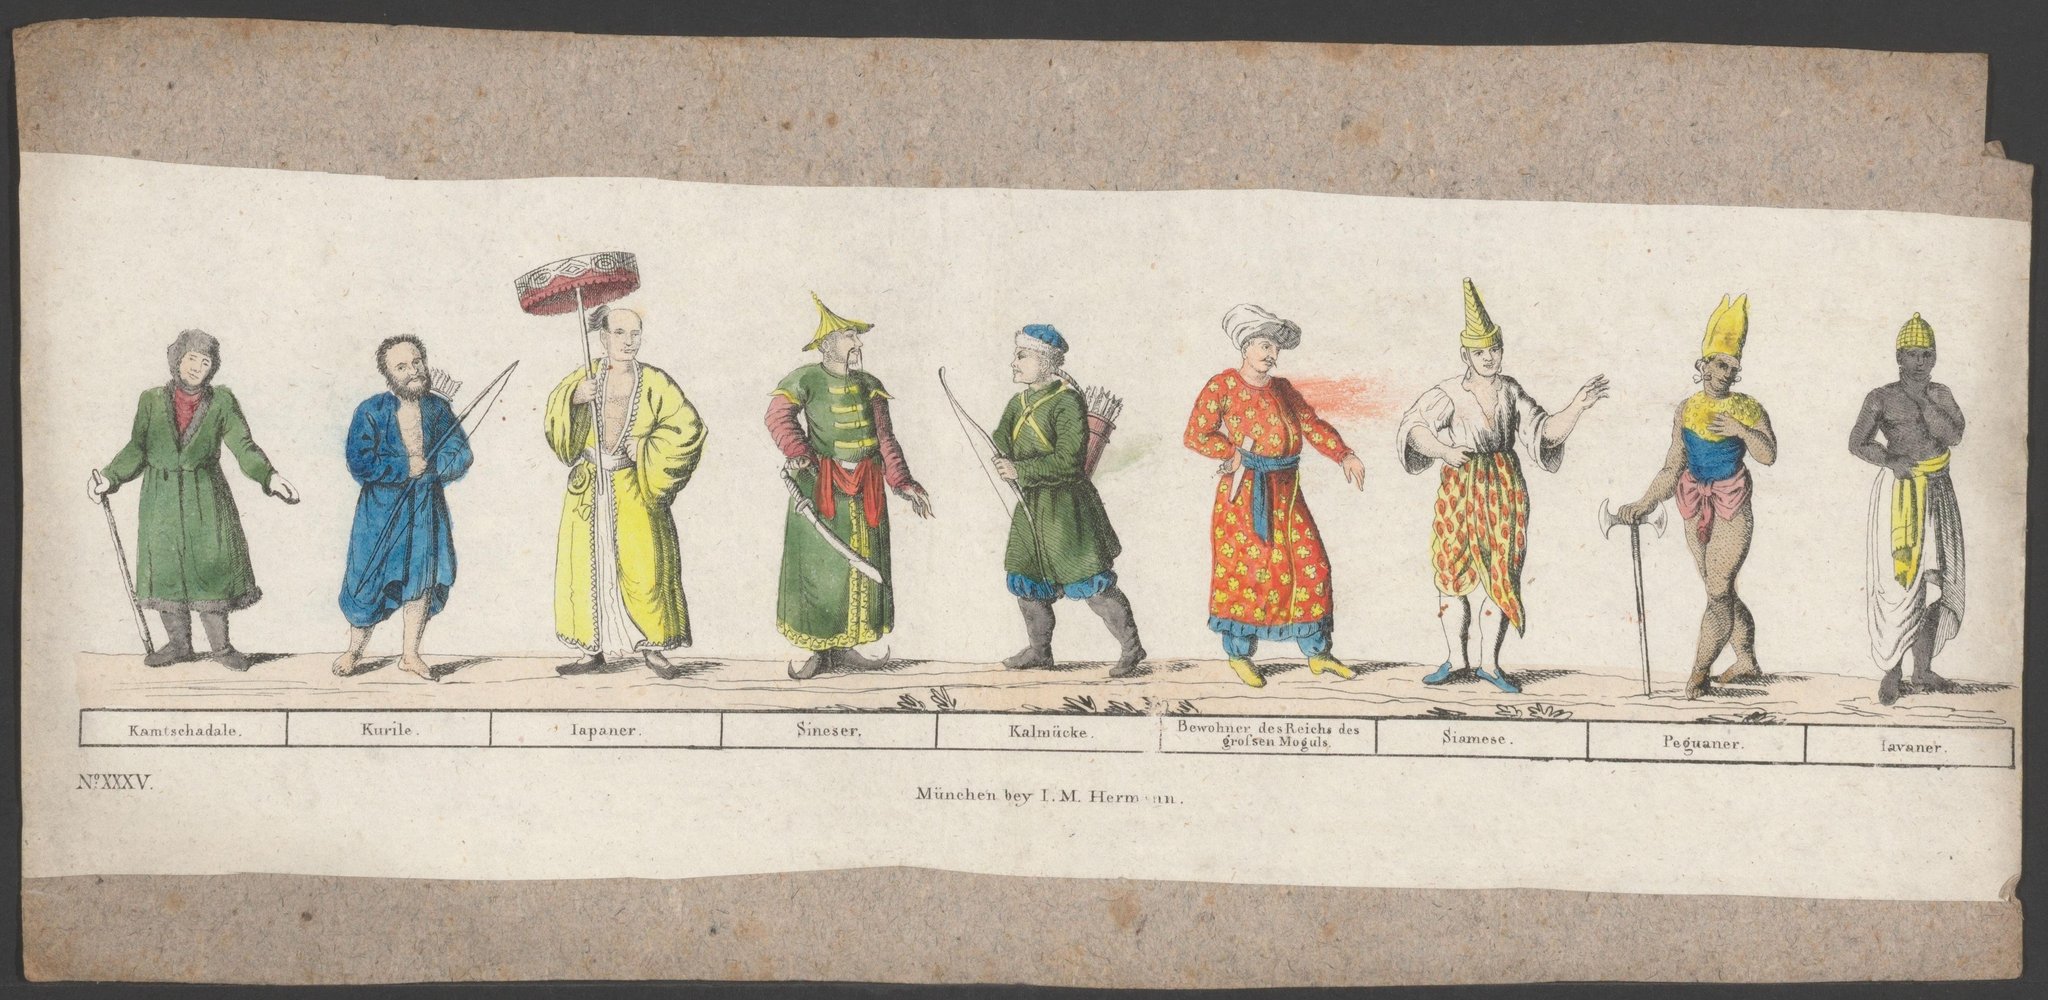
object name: print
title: Kostuums van diverse bevolkingsgroepen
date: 1800-1849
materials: paper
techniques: etching, hand coloring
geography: munich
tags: historical costume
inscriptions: collector's mark: Lugt 1641, stamp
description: Linksonder genummerd: No. XXXV. Onderwerpsrubrieken binnen de Atlas Zeden en Gewoonten: Zeden en gewoonten in engeren zin, Des menschen begin, midden en einde, Kinderprenten opgeplakt op karton.